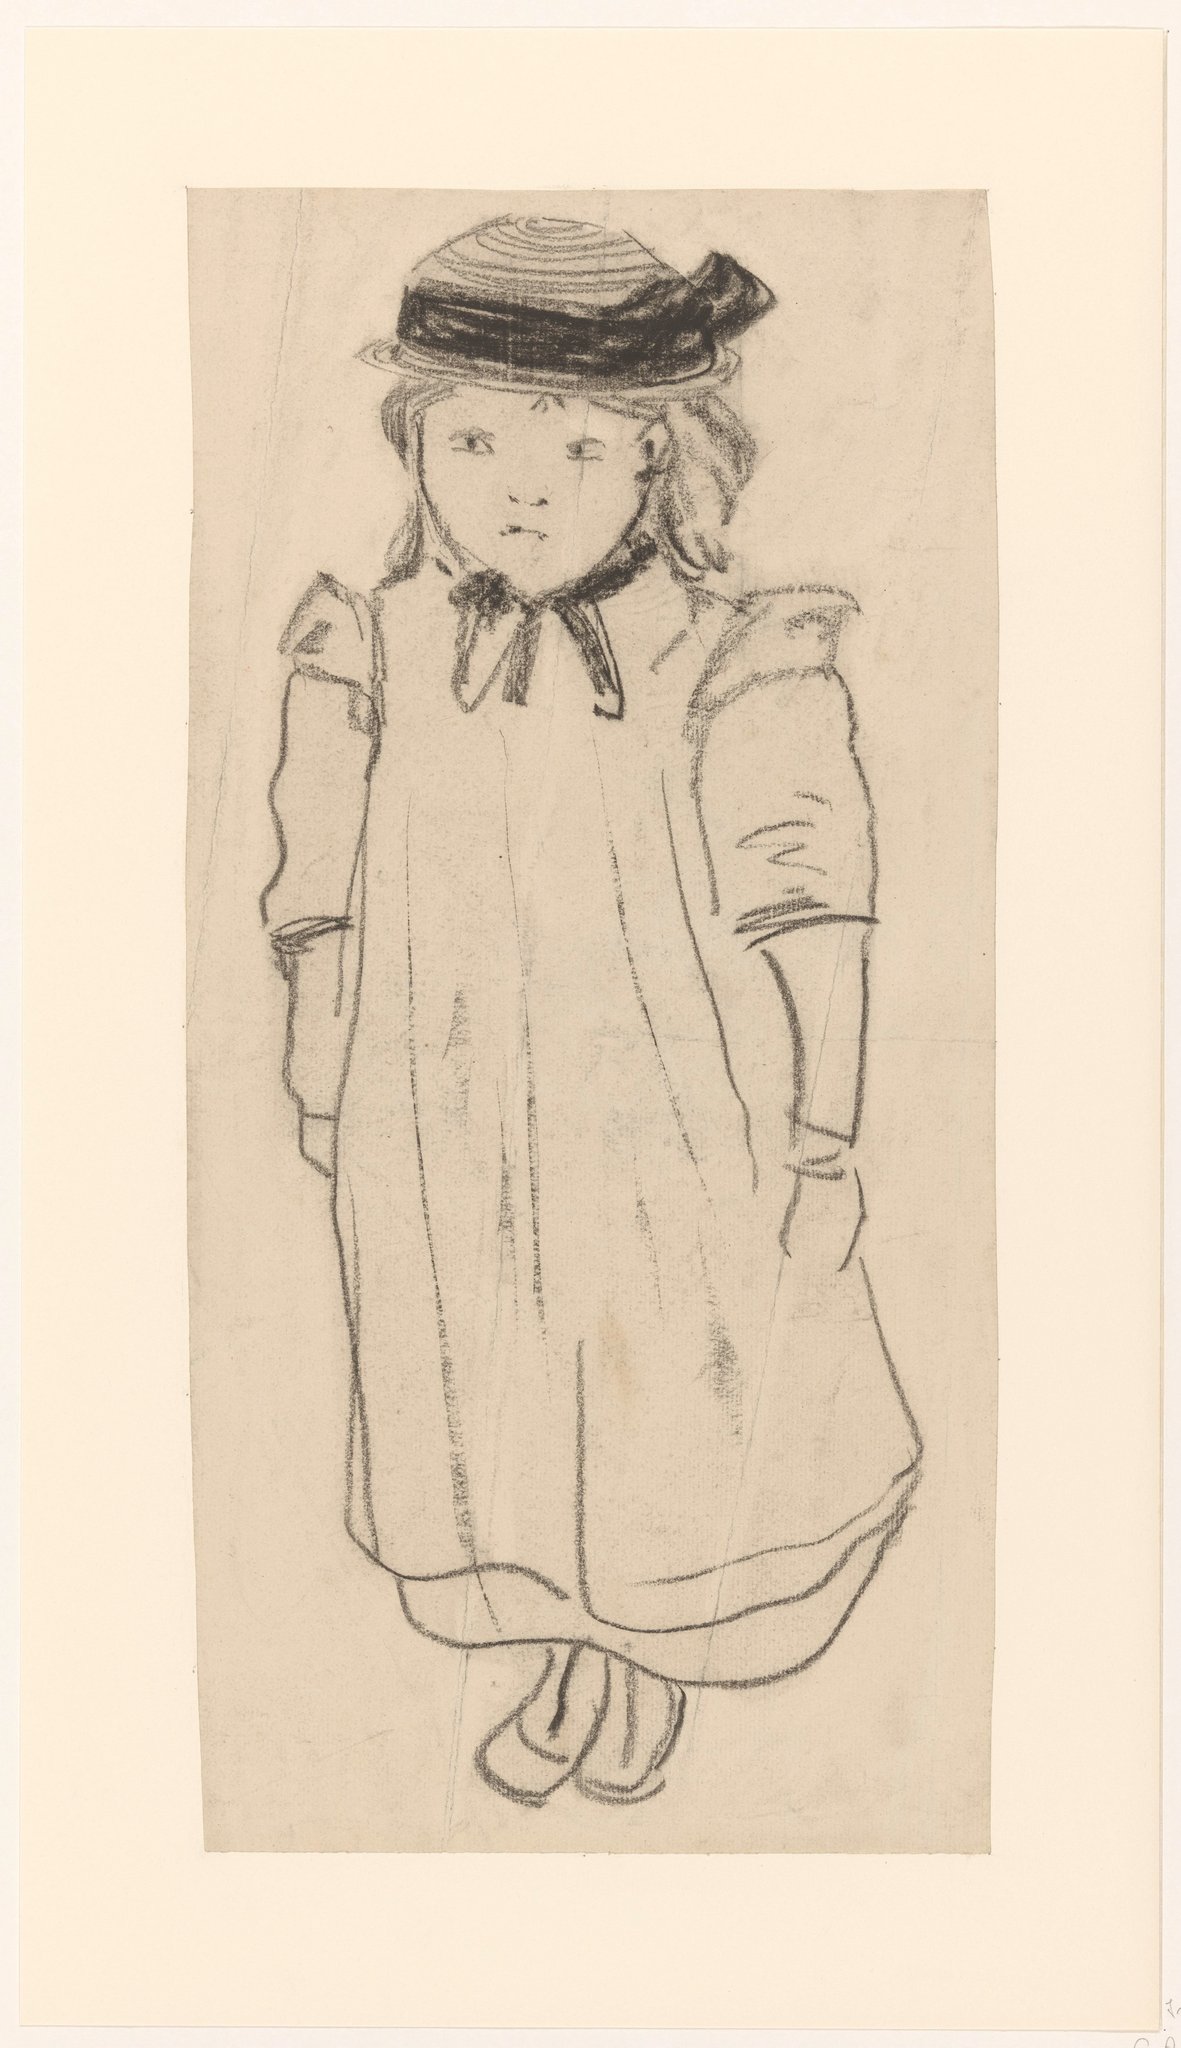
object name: drawing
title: Staand meisje met hoed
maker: carel adolph lion cachet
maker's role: draughtsman, print maker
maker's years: 1864-1945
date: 1874-1945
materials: chalk, paper